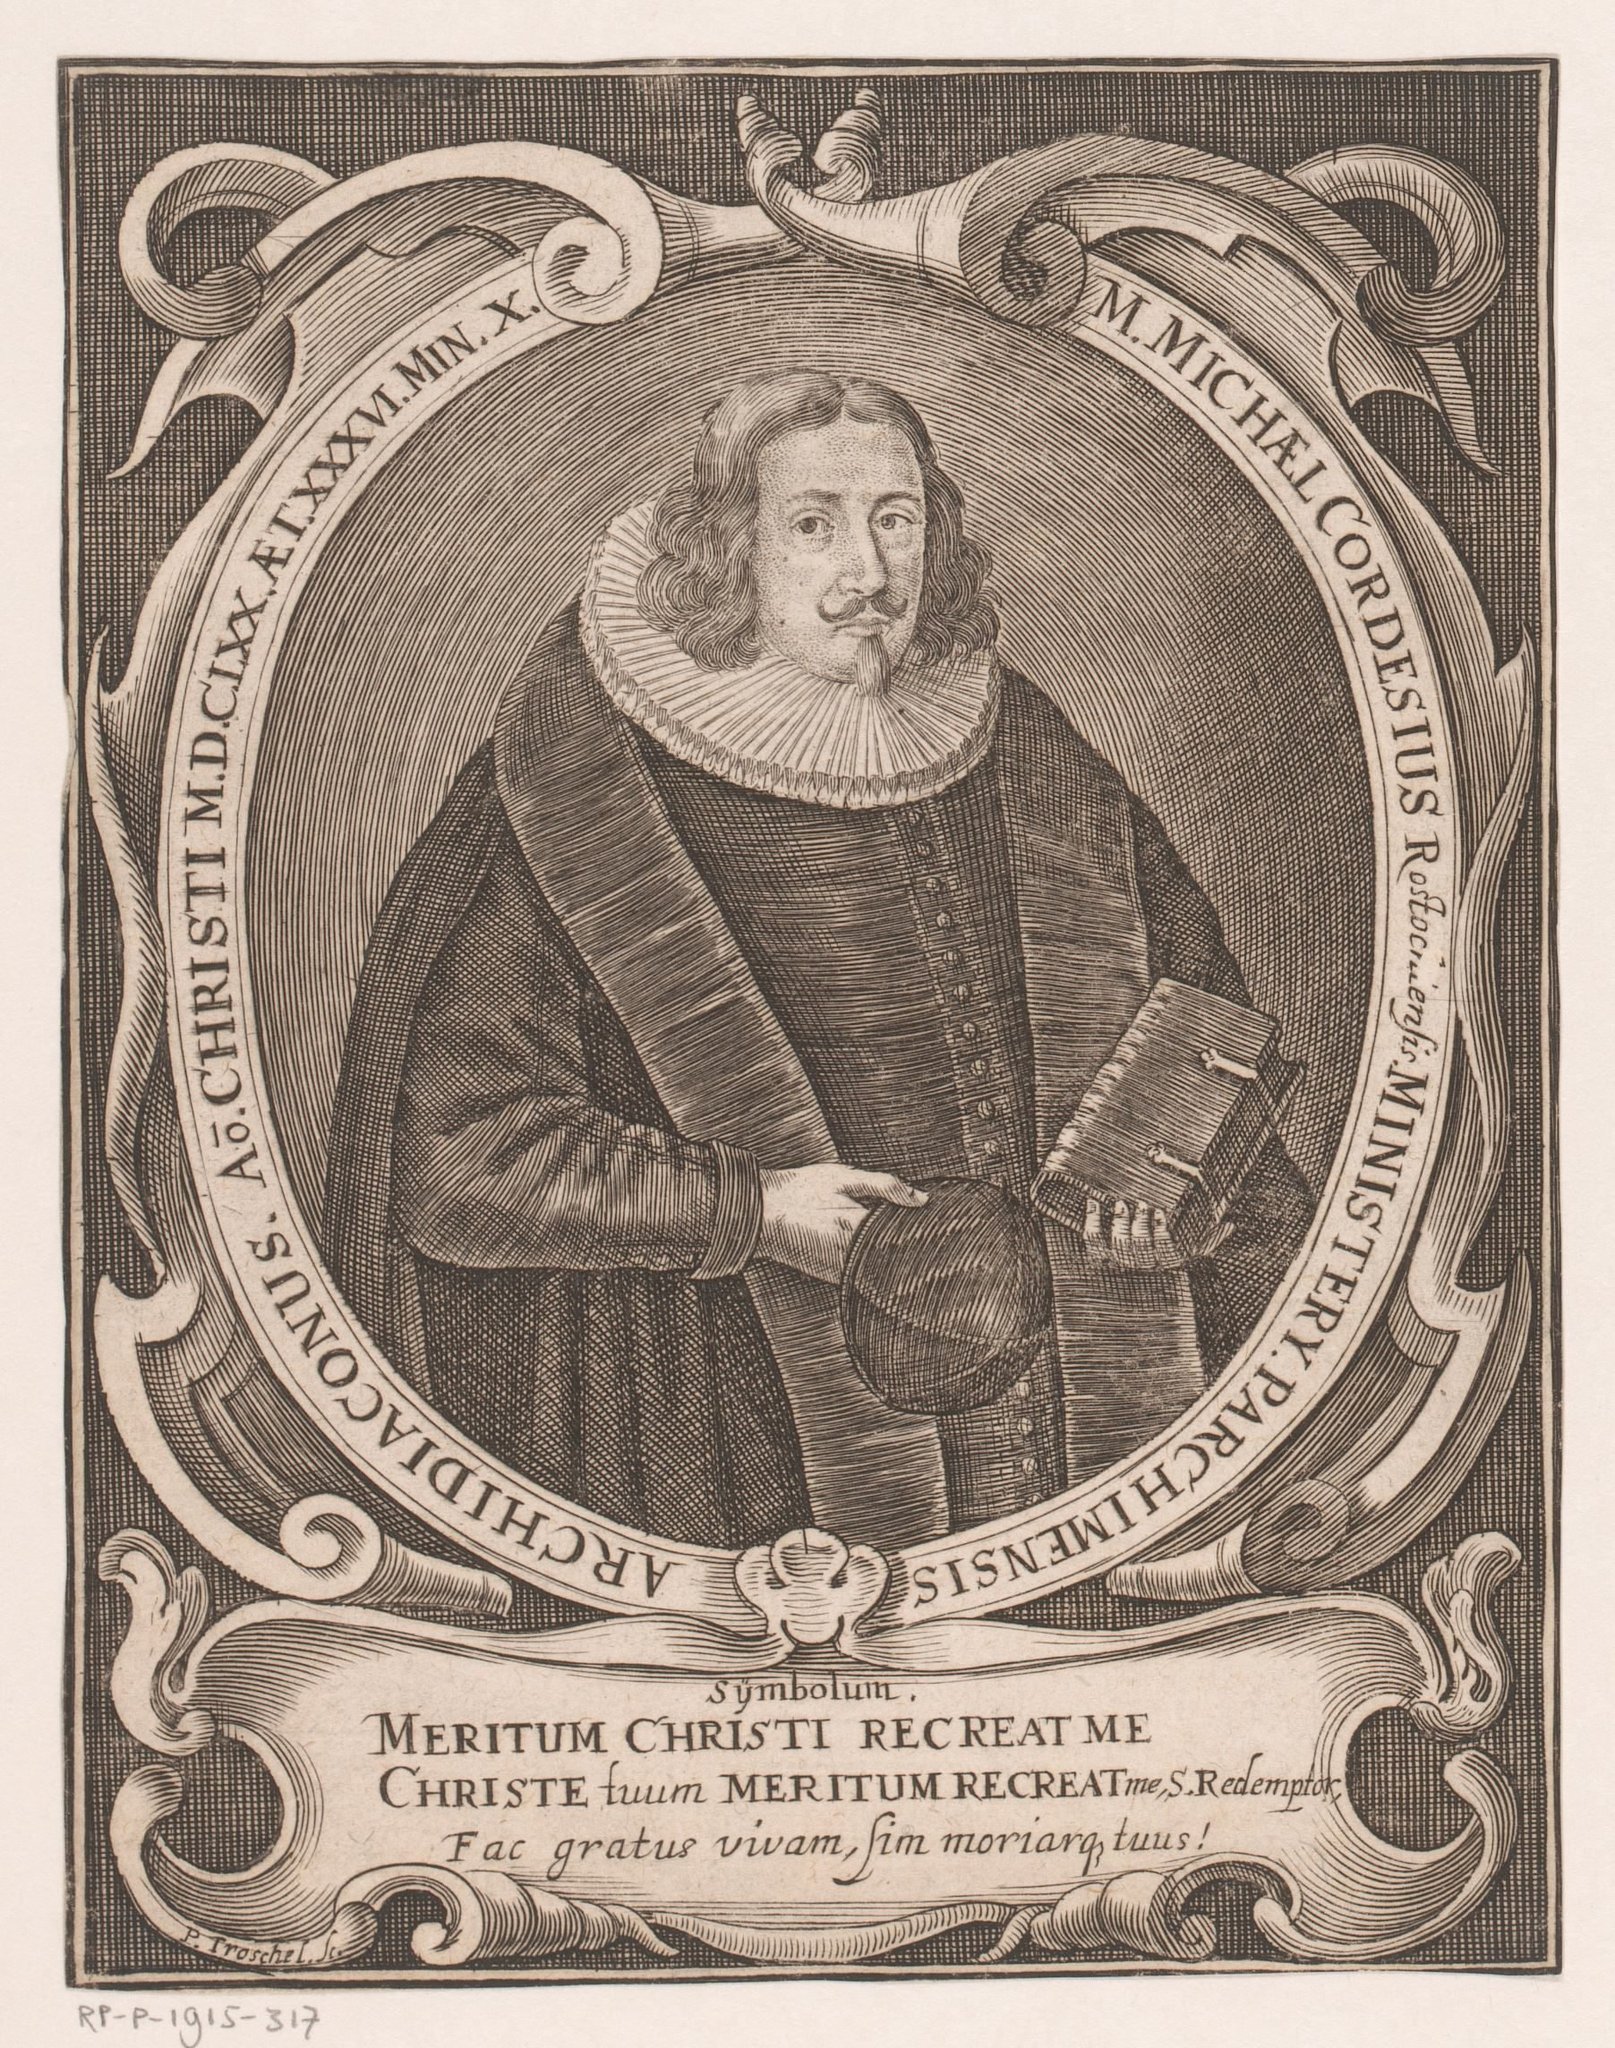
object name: print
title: Portret van Michael Cordes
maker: peter troschel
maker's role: draughtsman, print maker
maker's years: 1620-1670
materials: paper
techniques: engraving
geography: germany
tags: historical persons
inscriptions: collector's mark: Lugt 2228